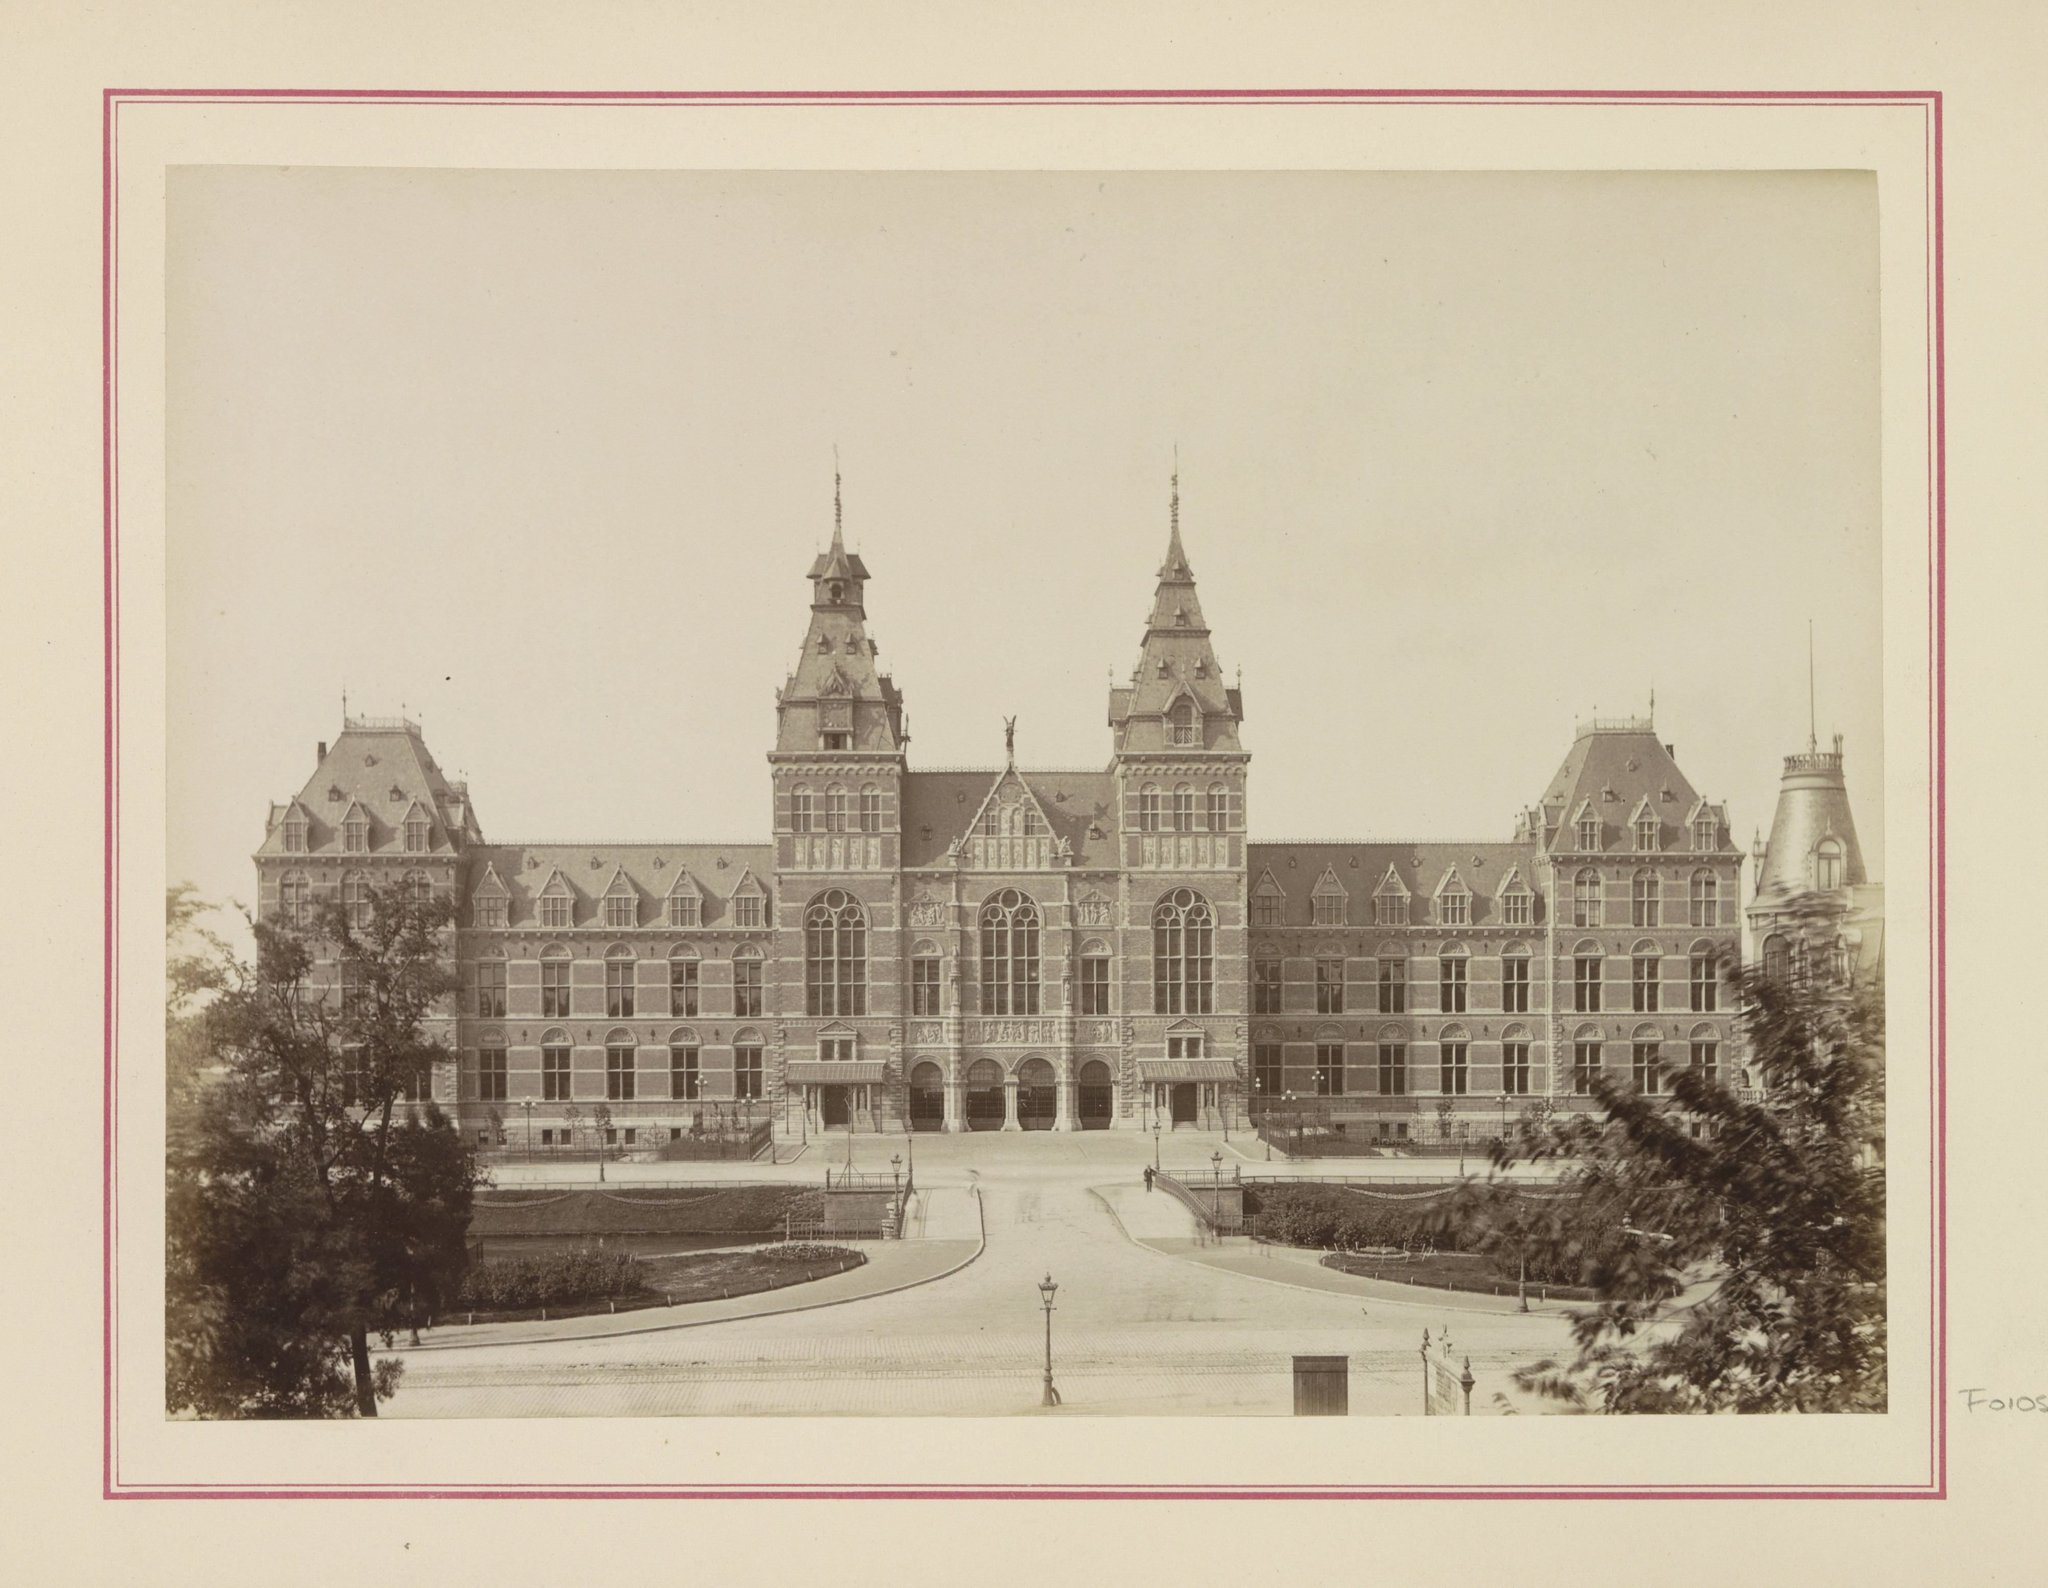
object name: photograph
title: Rijksmuseum in Amsterdam gezien vanuit het noorden met op de voorgrond de Museumbrug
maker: Anonymous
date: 1885-1900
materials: photographic support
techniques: albumen print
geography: amsterdam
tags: permanent exhibition, museum, façade (of house or building), bridge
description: Onderdeel van Fotoalbum met opnames van bezienswaardigheden in Amsterdam.